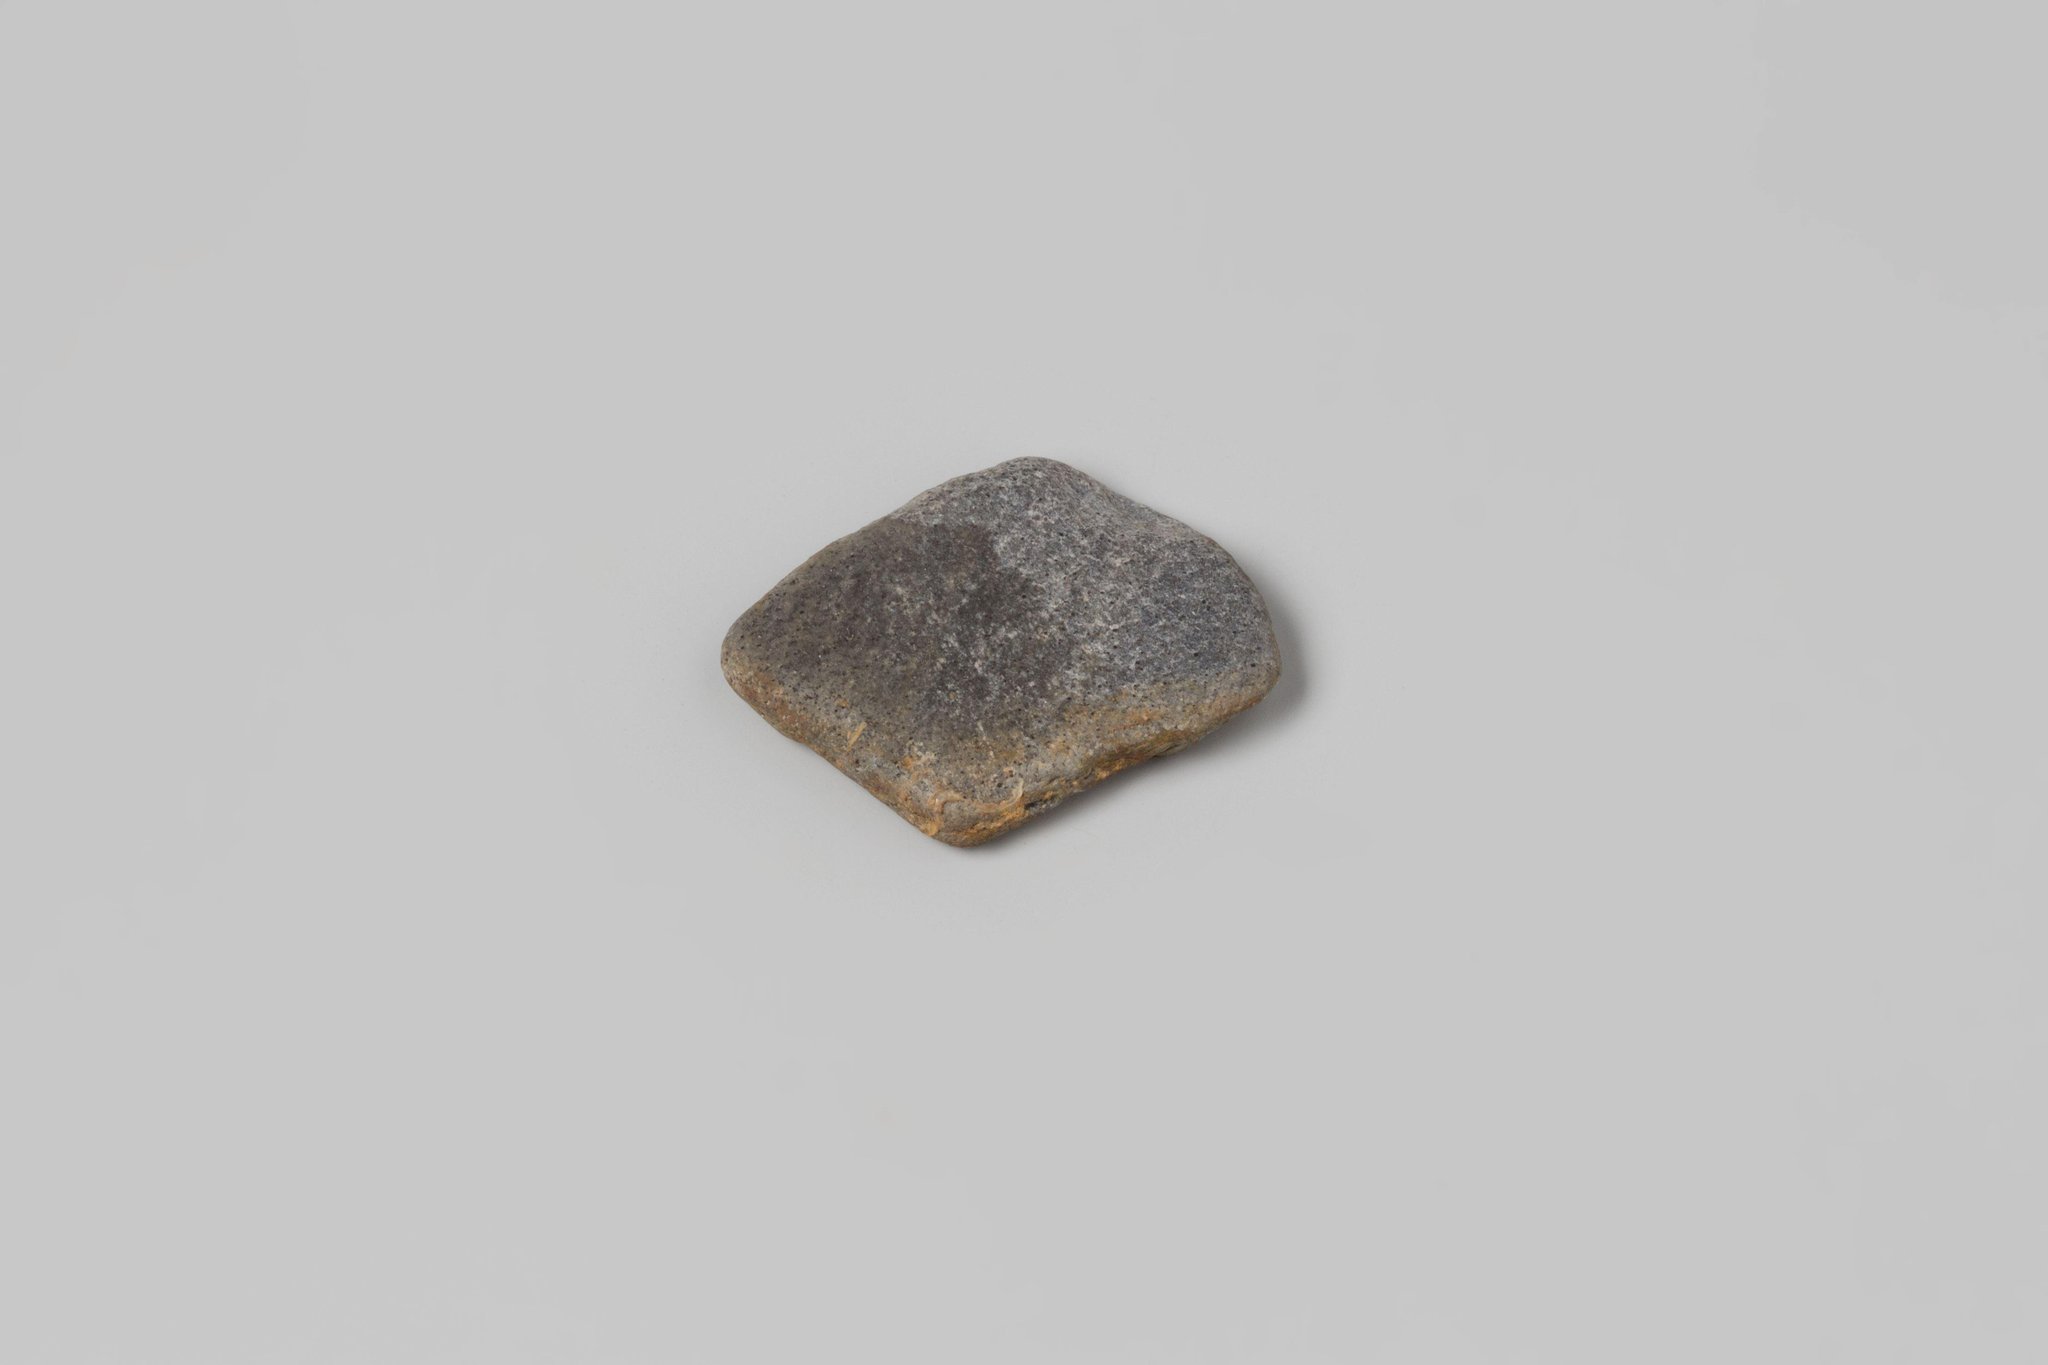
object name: scheepswrakvondst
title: Fragment leisteen uit het wrak van de Oost-Indiëvaarder Hollandia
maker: Anonymous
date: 1700-1743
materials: stone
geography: netherlands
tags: verenigde oostindische compagnie, hollandia (schip), annet